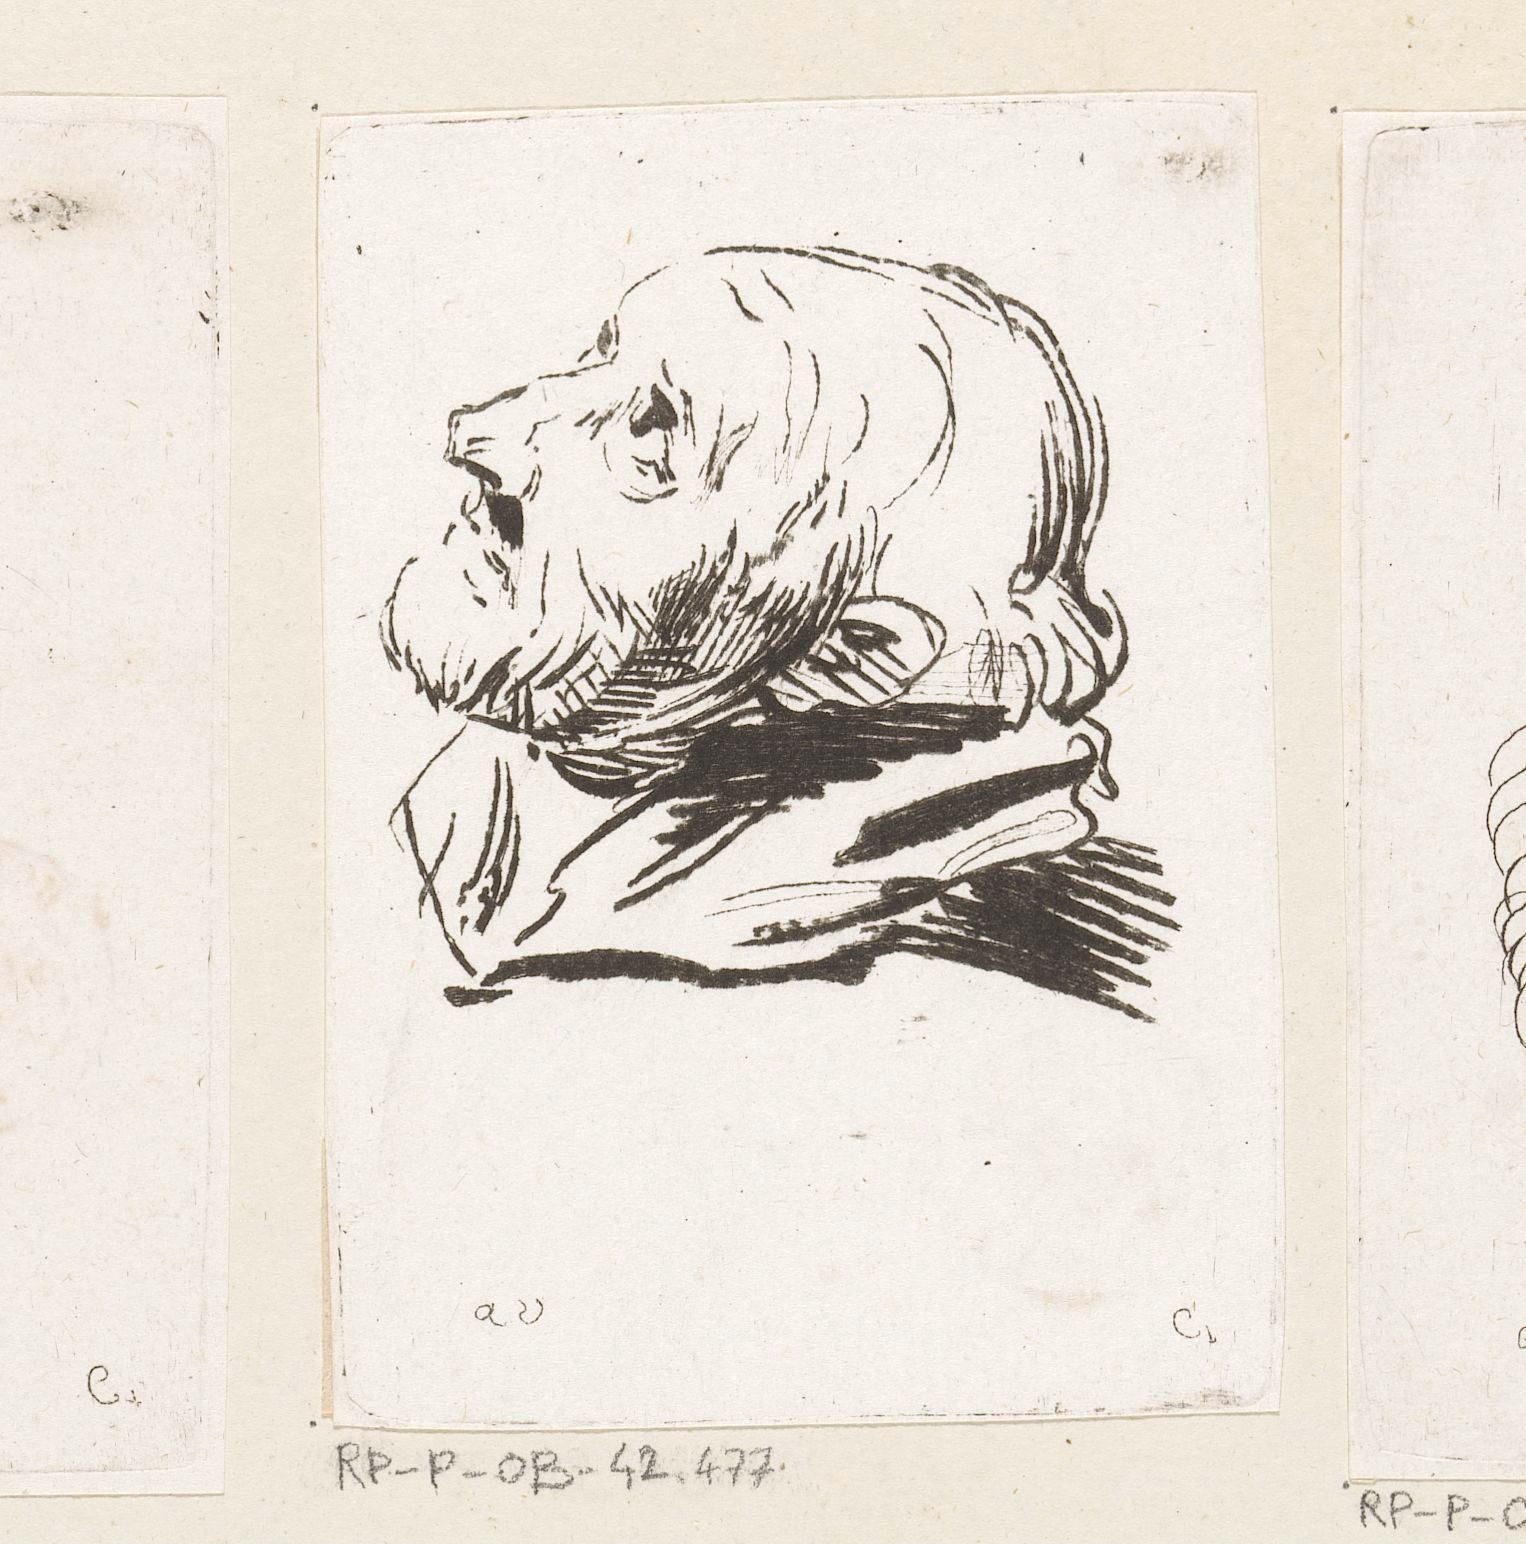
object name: print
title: Hoofd van een omhoog kijkende man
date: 1735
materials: paper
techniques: etching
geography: france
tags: head (human), old man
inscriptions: collector's mark: Lugt 240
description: Prent uit een serie van 31 prenten naar getekende hoofden door Van Dyck, plus een titelprent naar Bouchardon, getiteld: "Recueil de Testes d'Antoine Van Dyck tirées du Cabinet de M. Crozat et gravées par M. le C. de C.".